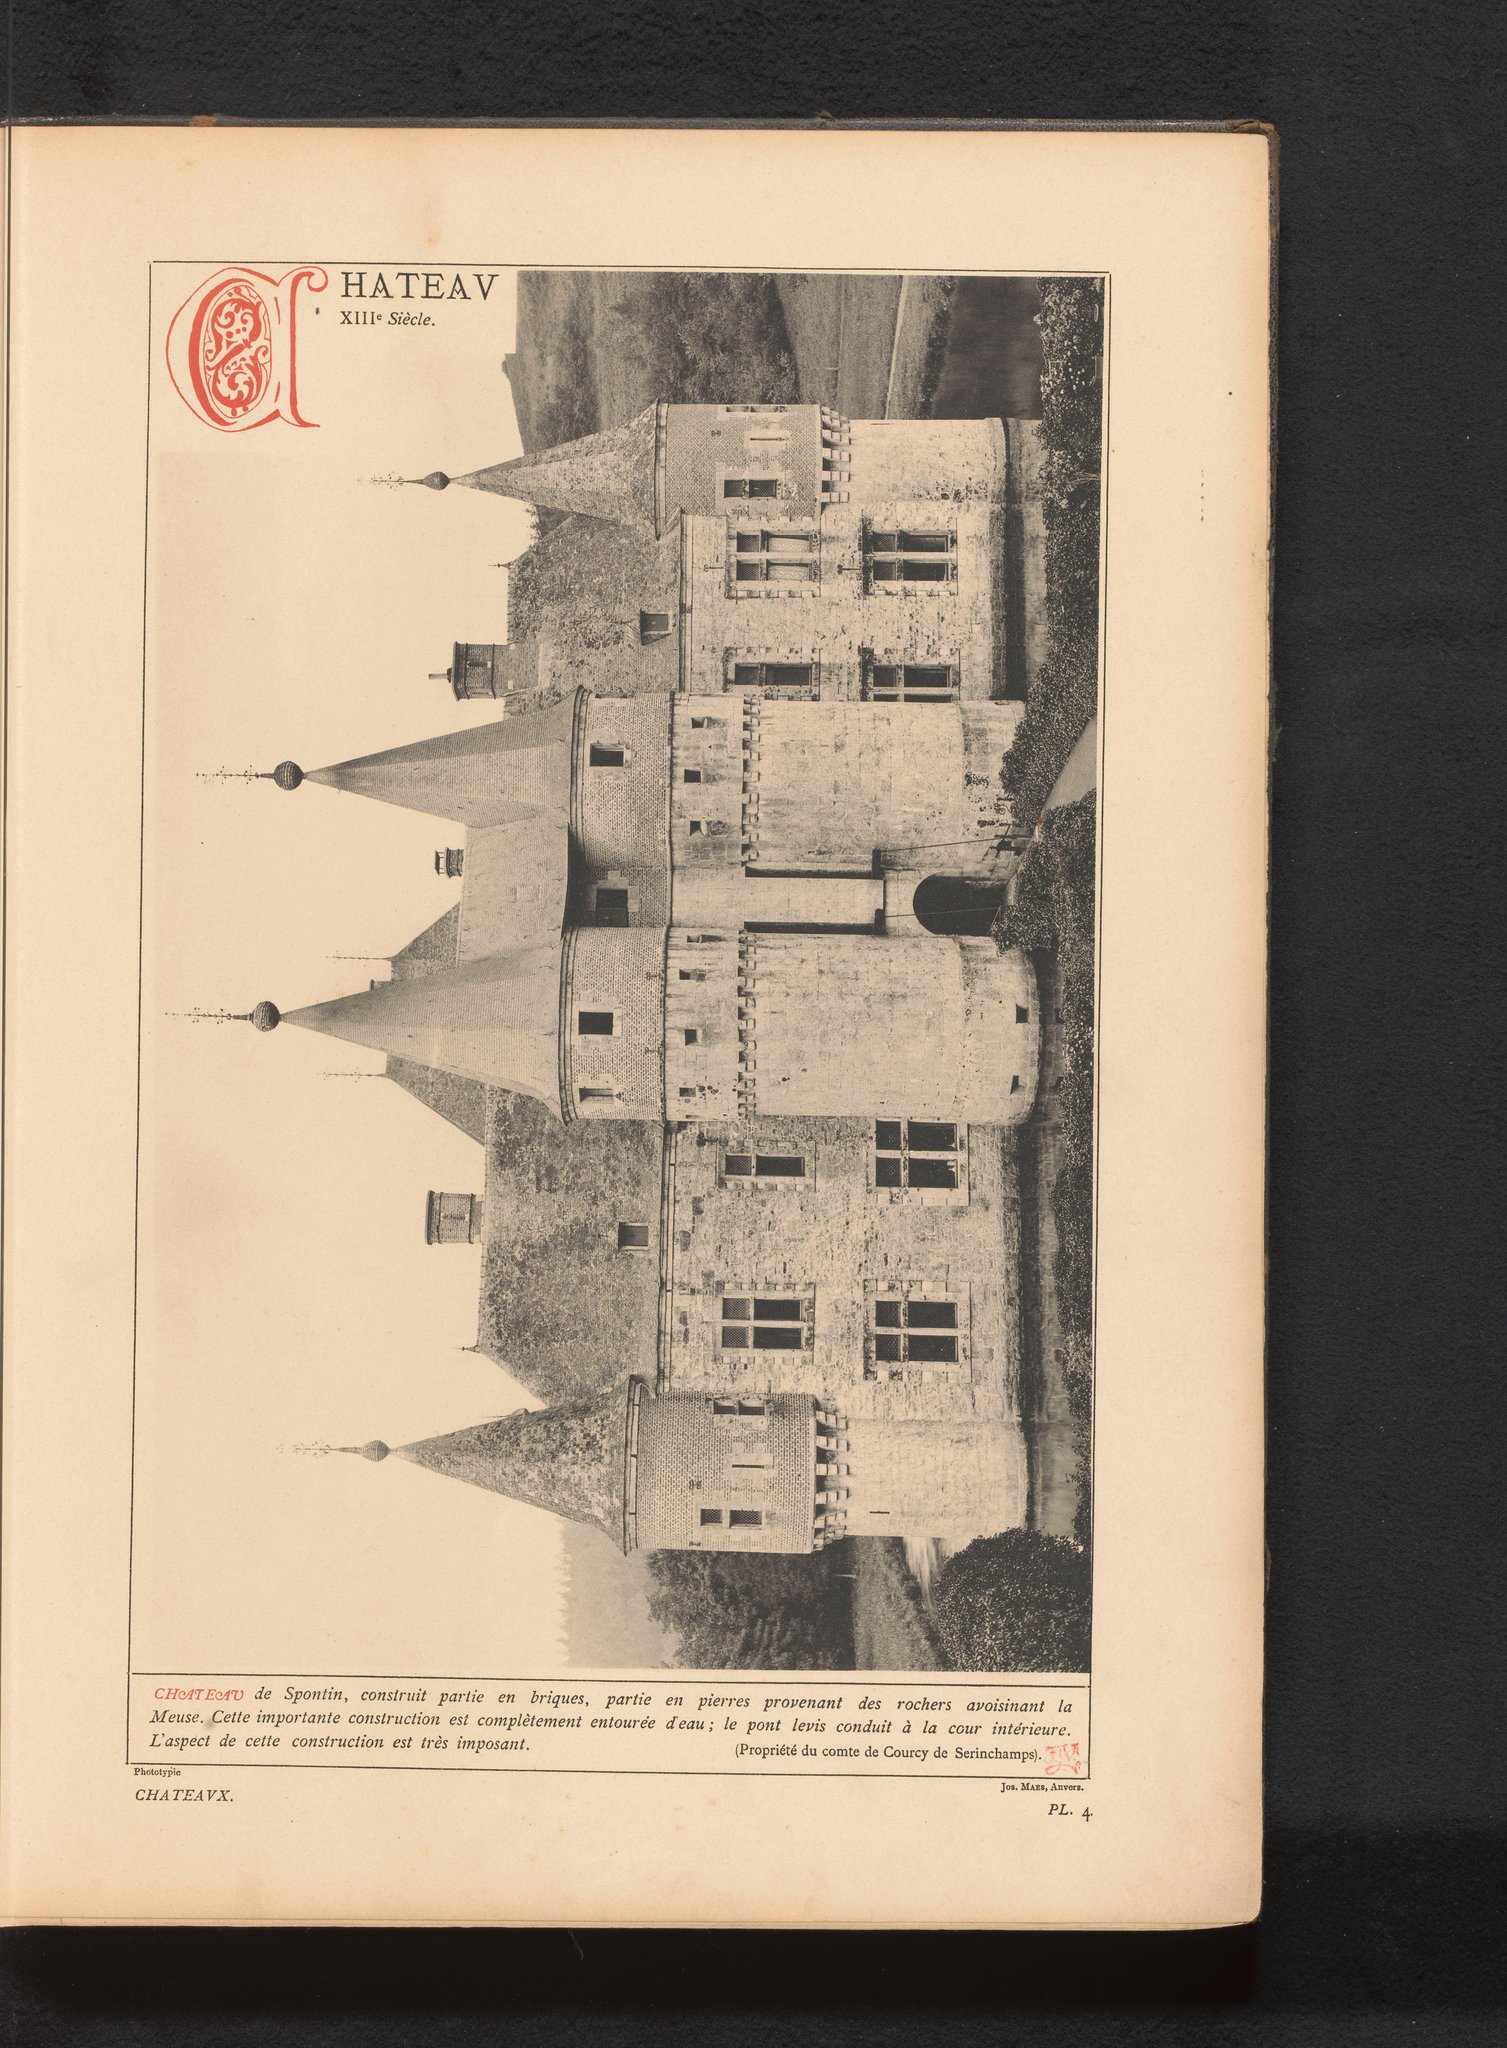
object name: page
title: Gezicht op kasteel van Spontin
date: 1881-1889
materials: paper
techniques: photograph, photolithography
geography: antwerp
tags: castle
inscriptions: inscription: ‘CHATEAU de Spontin (...)’, monogram: ‘JJvY’, inscription: ‘CHATEAU. PL.4.’